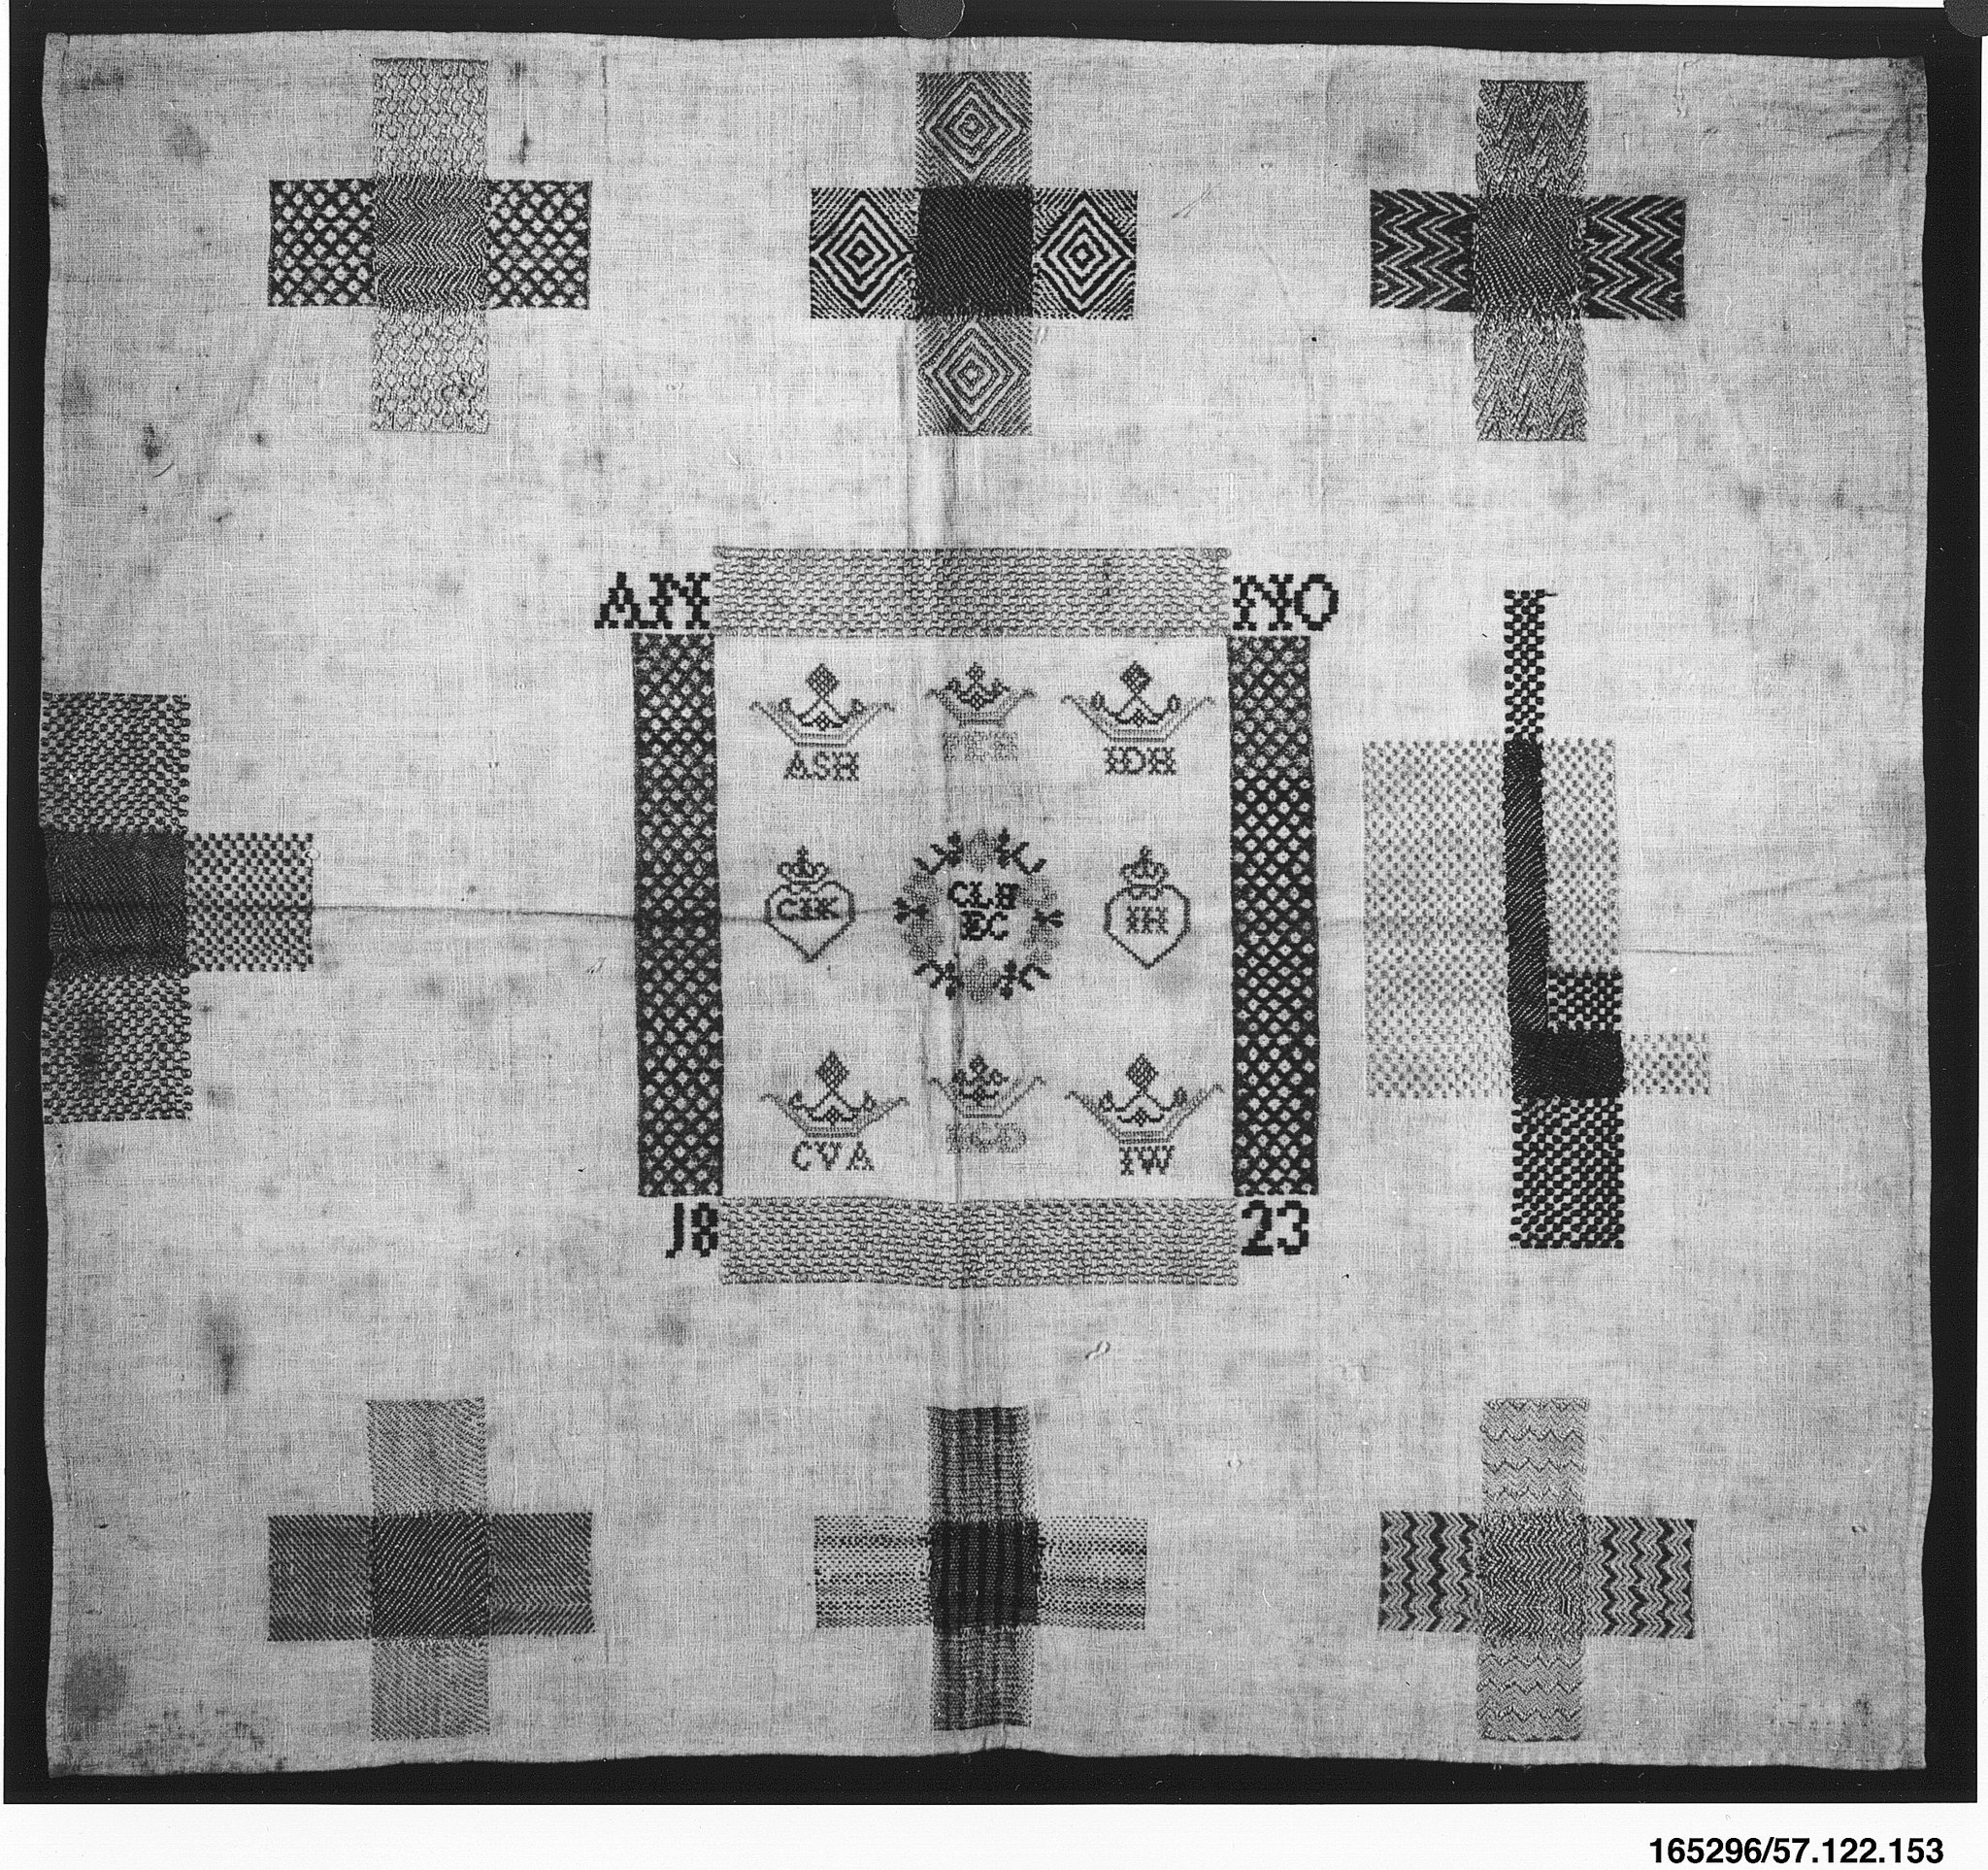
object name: sampler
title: Embroidered darning sampler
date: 1823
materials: cotton, silk